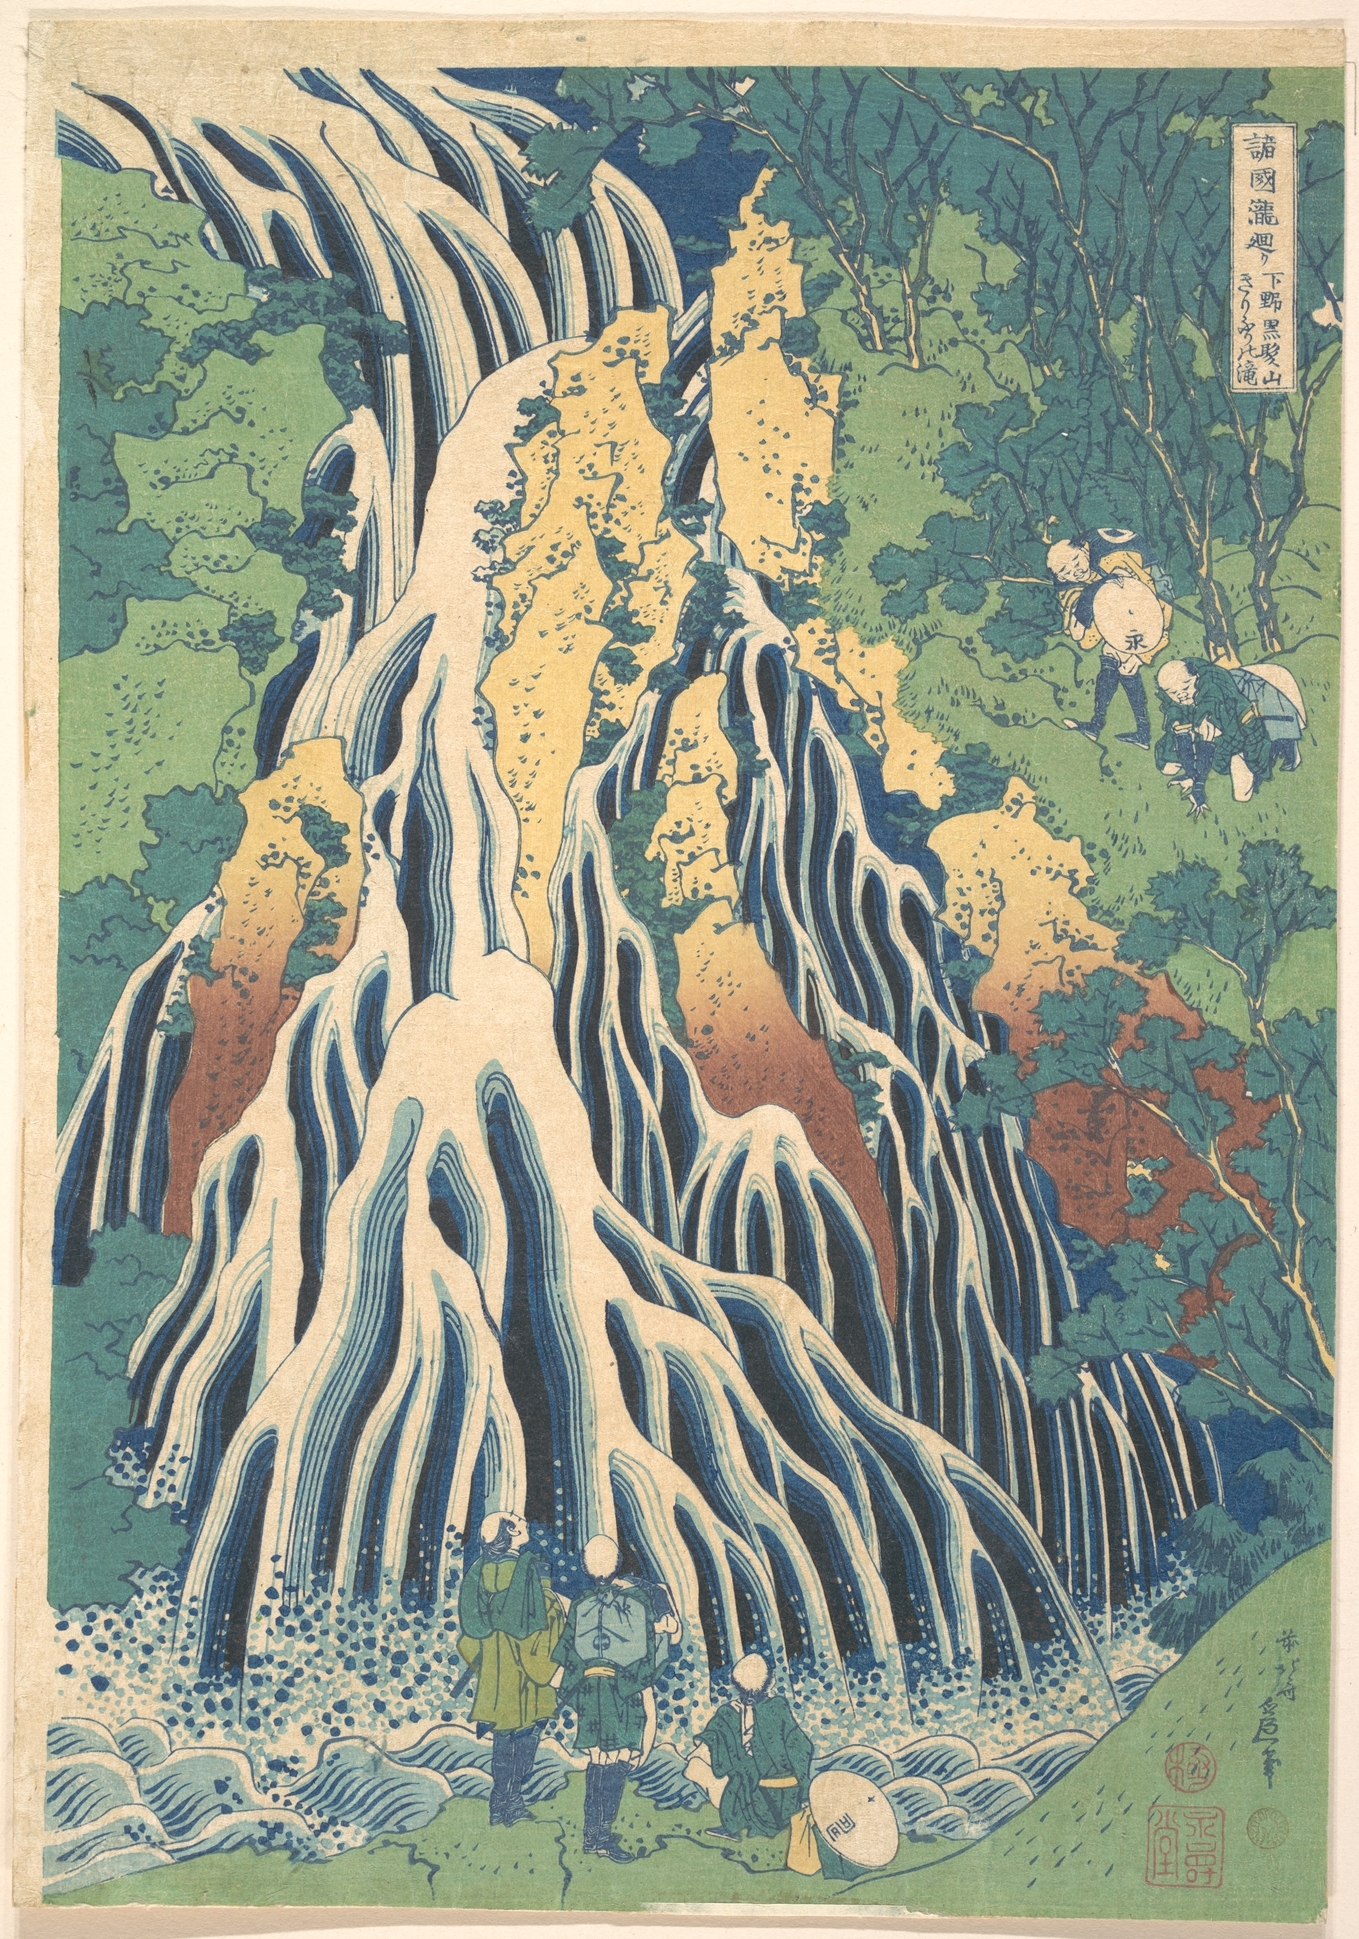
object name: woodblock print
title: Kirifuri Waterfall at Kurokami Mountain in Shimotsuke (Shimotsuke Kurokamiyama Kirifuri no taki), from the series A Tour of Waterfalls in Various Provinces (Shokoku taki meguri)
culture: japanese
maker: katsushika hokusai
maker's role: artist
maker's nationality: japanese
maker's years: 1760-1849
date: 1832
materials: ink, paper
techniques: woodblock print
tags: human figures,waterfalls,mountains,trees